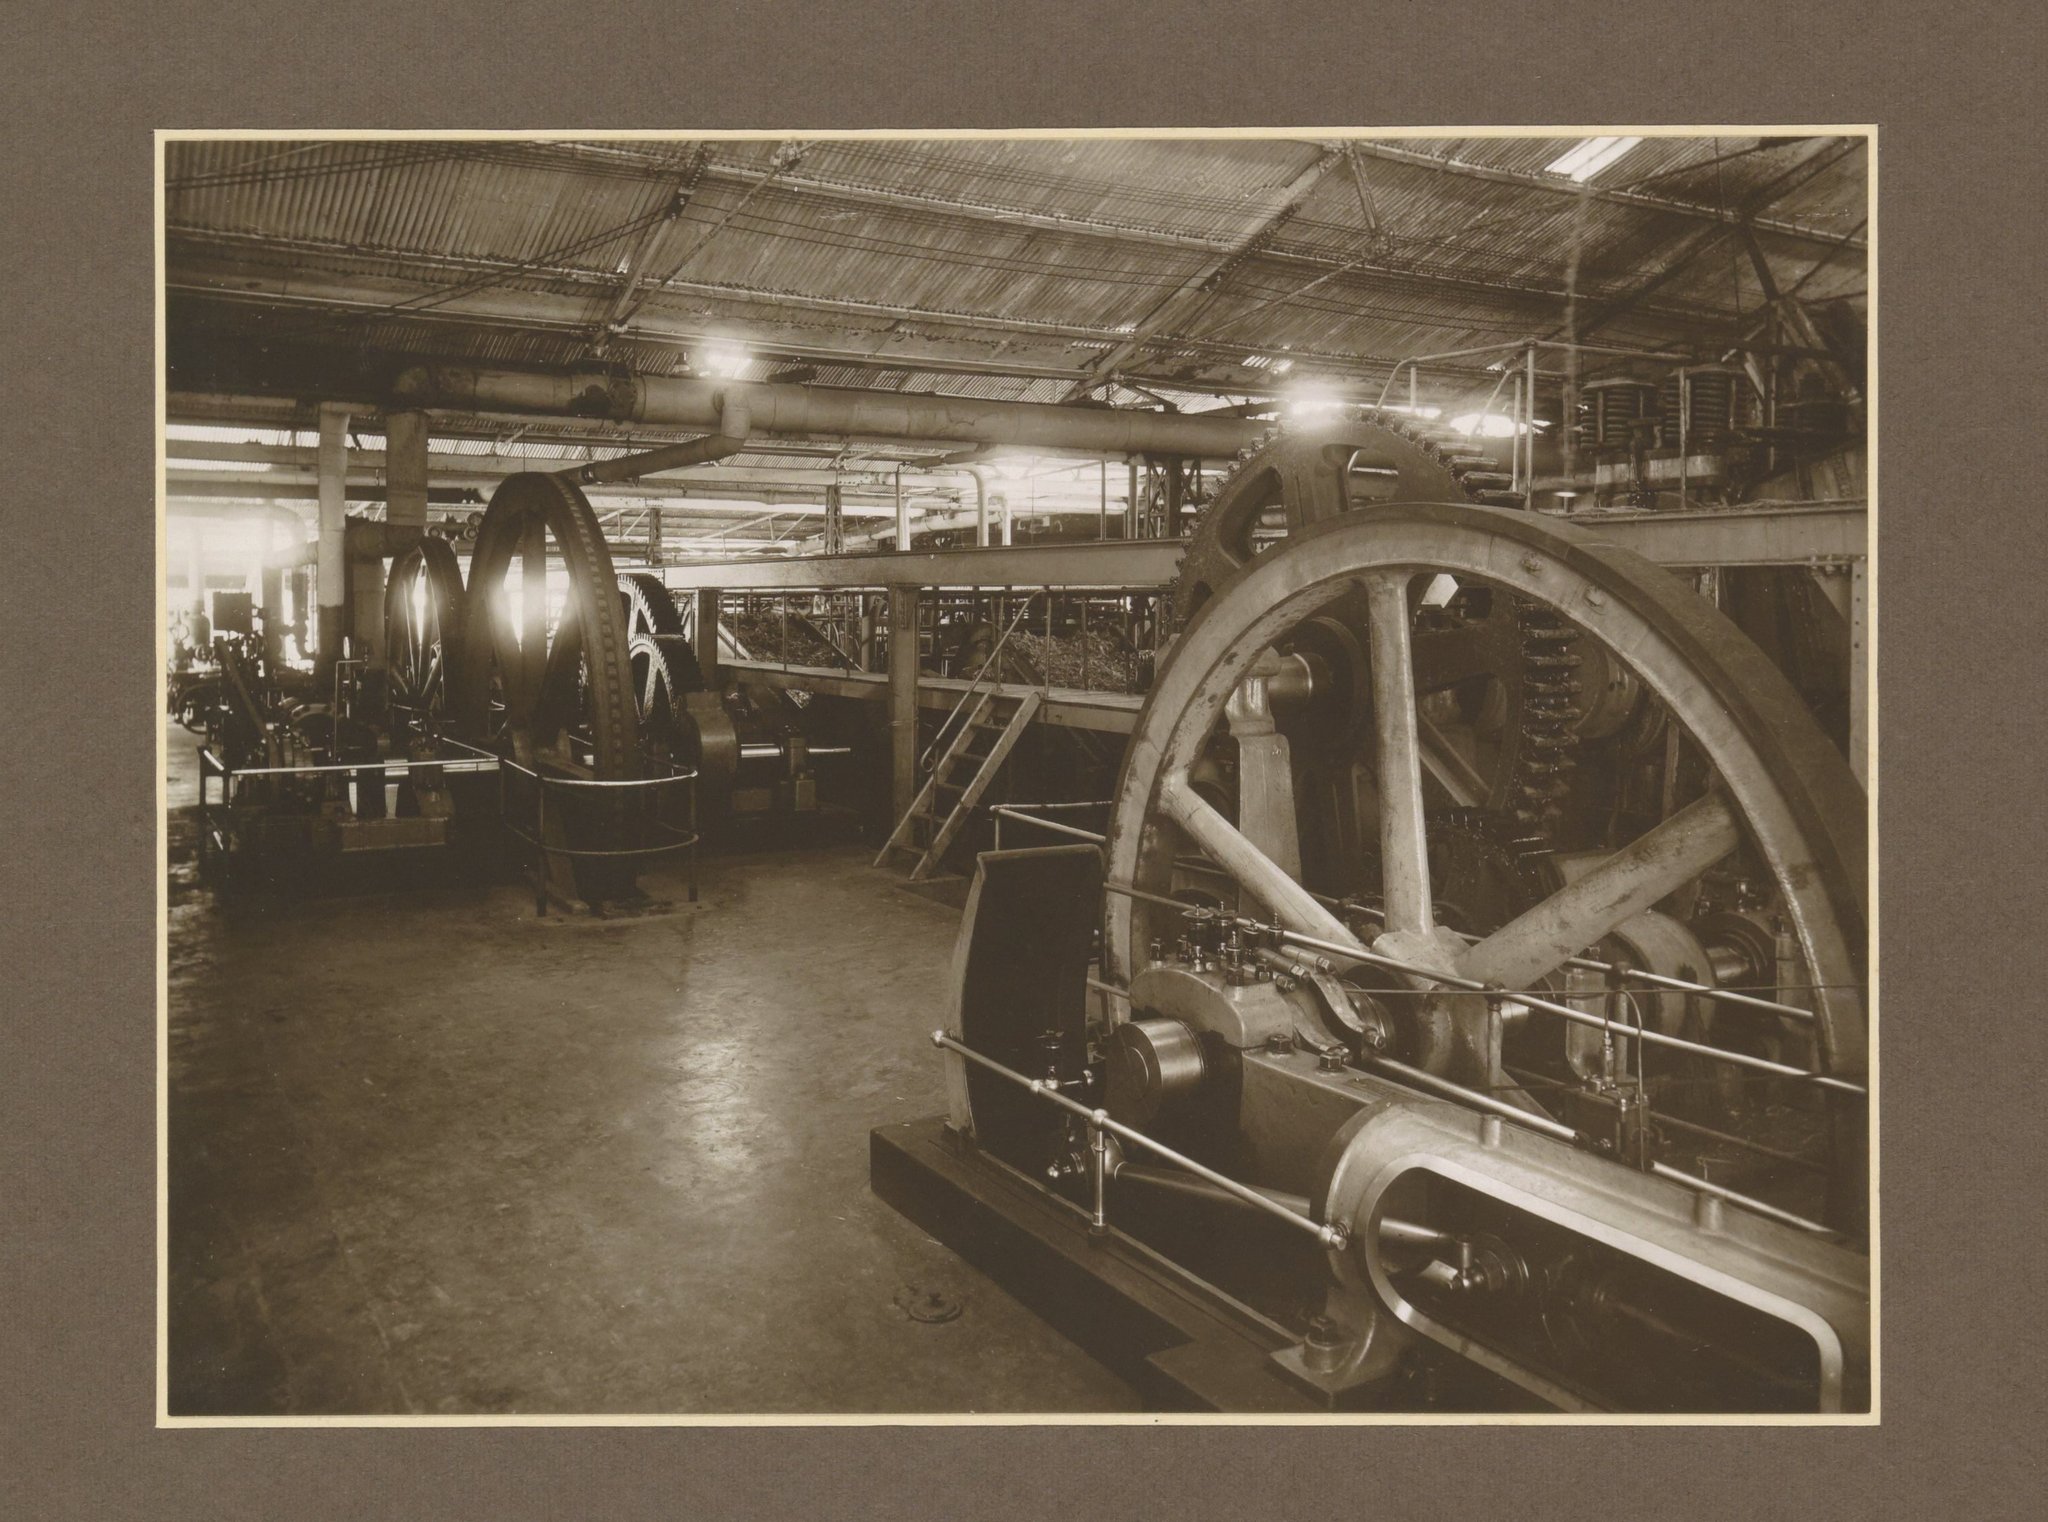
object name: photograph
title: Machines in een hal van suikerfabriek Meritjan te Kediri op Java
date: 1925-1930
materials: cardboard, paper, photographic support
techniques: gelatin silver print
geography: kediri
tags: plantation, factory-interior, machine shop, plants and herbs: sugarcane, sugar, dutch east indies, the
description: Onderdeel van Fotoalbum met opnames van vier suikerfabrieken op Java.